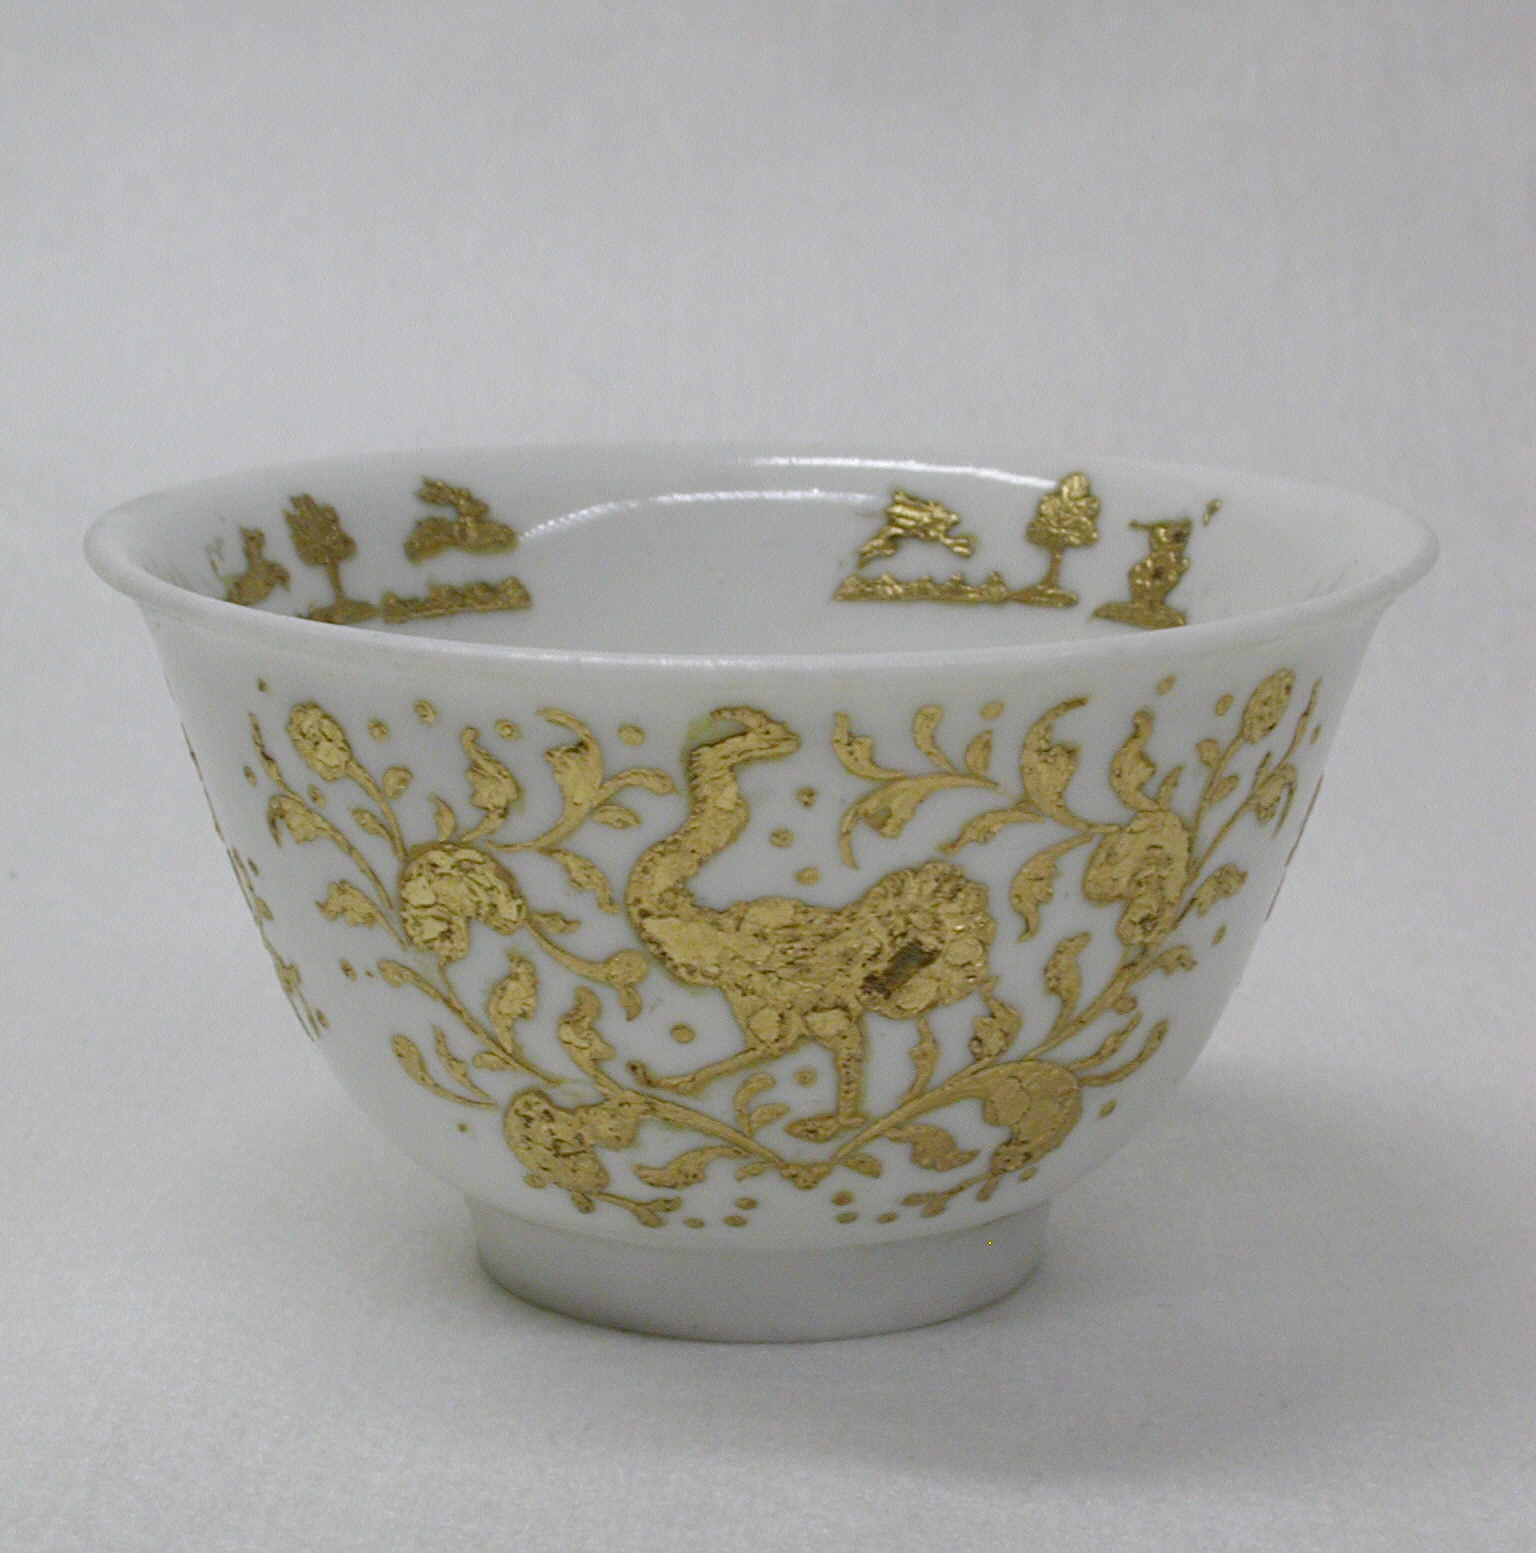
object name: teacup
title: Teacup (1 of 6) (part of a service)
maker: meissen manufactory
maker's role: manufactory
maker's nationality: german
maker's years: 1710-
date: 1720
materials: hard paste porcelain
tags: birds